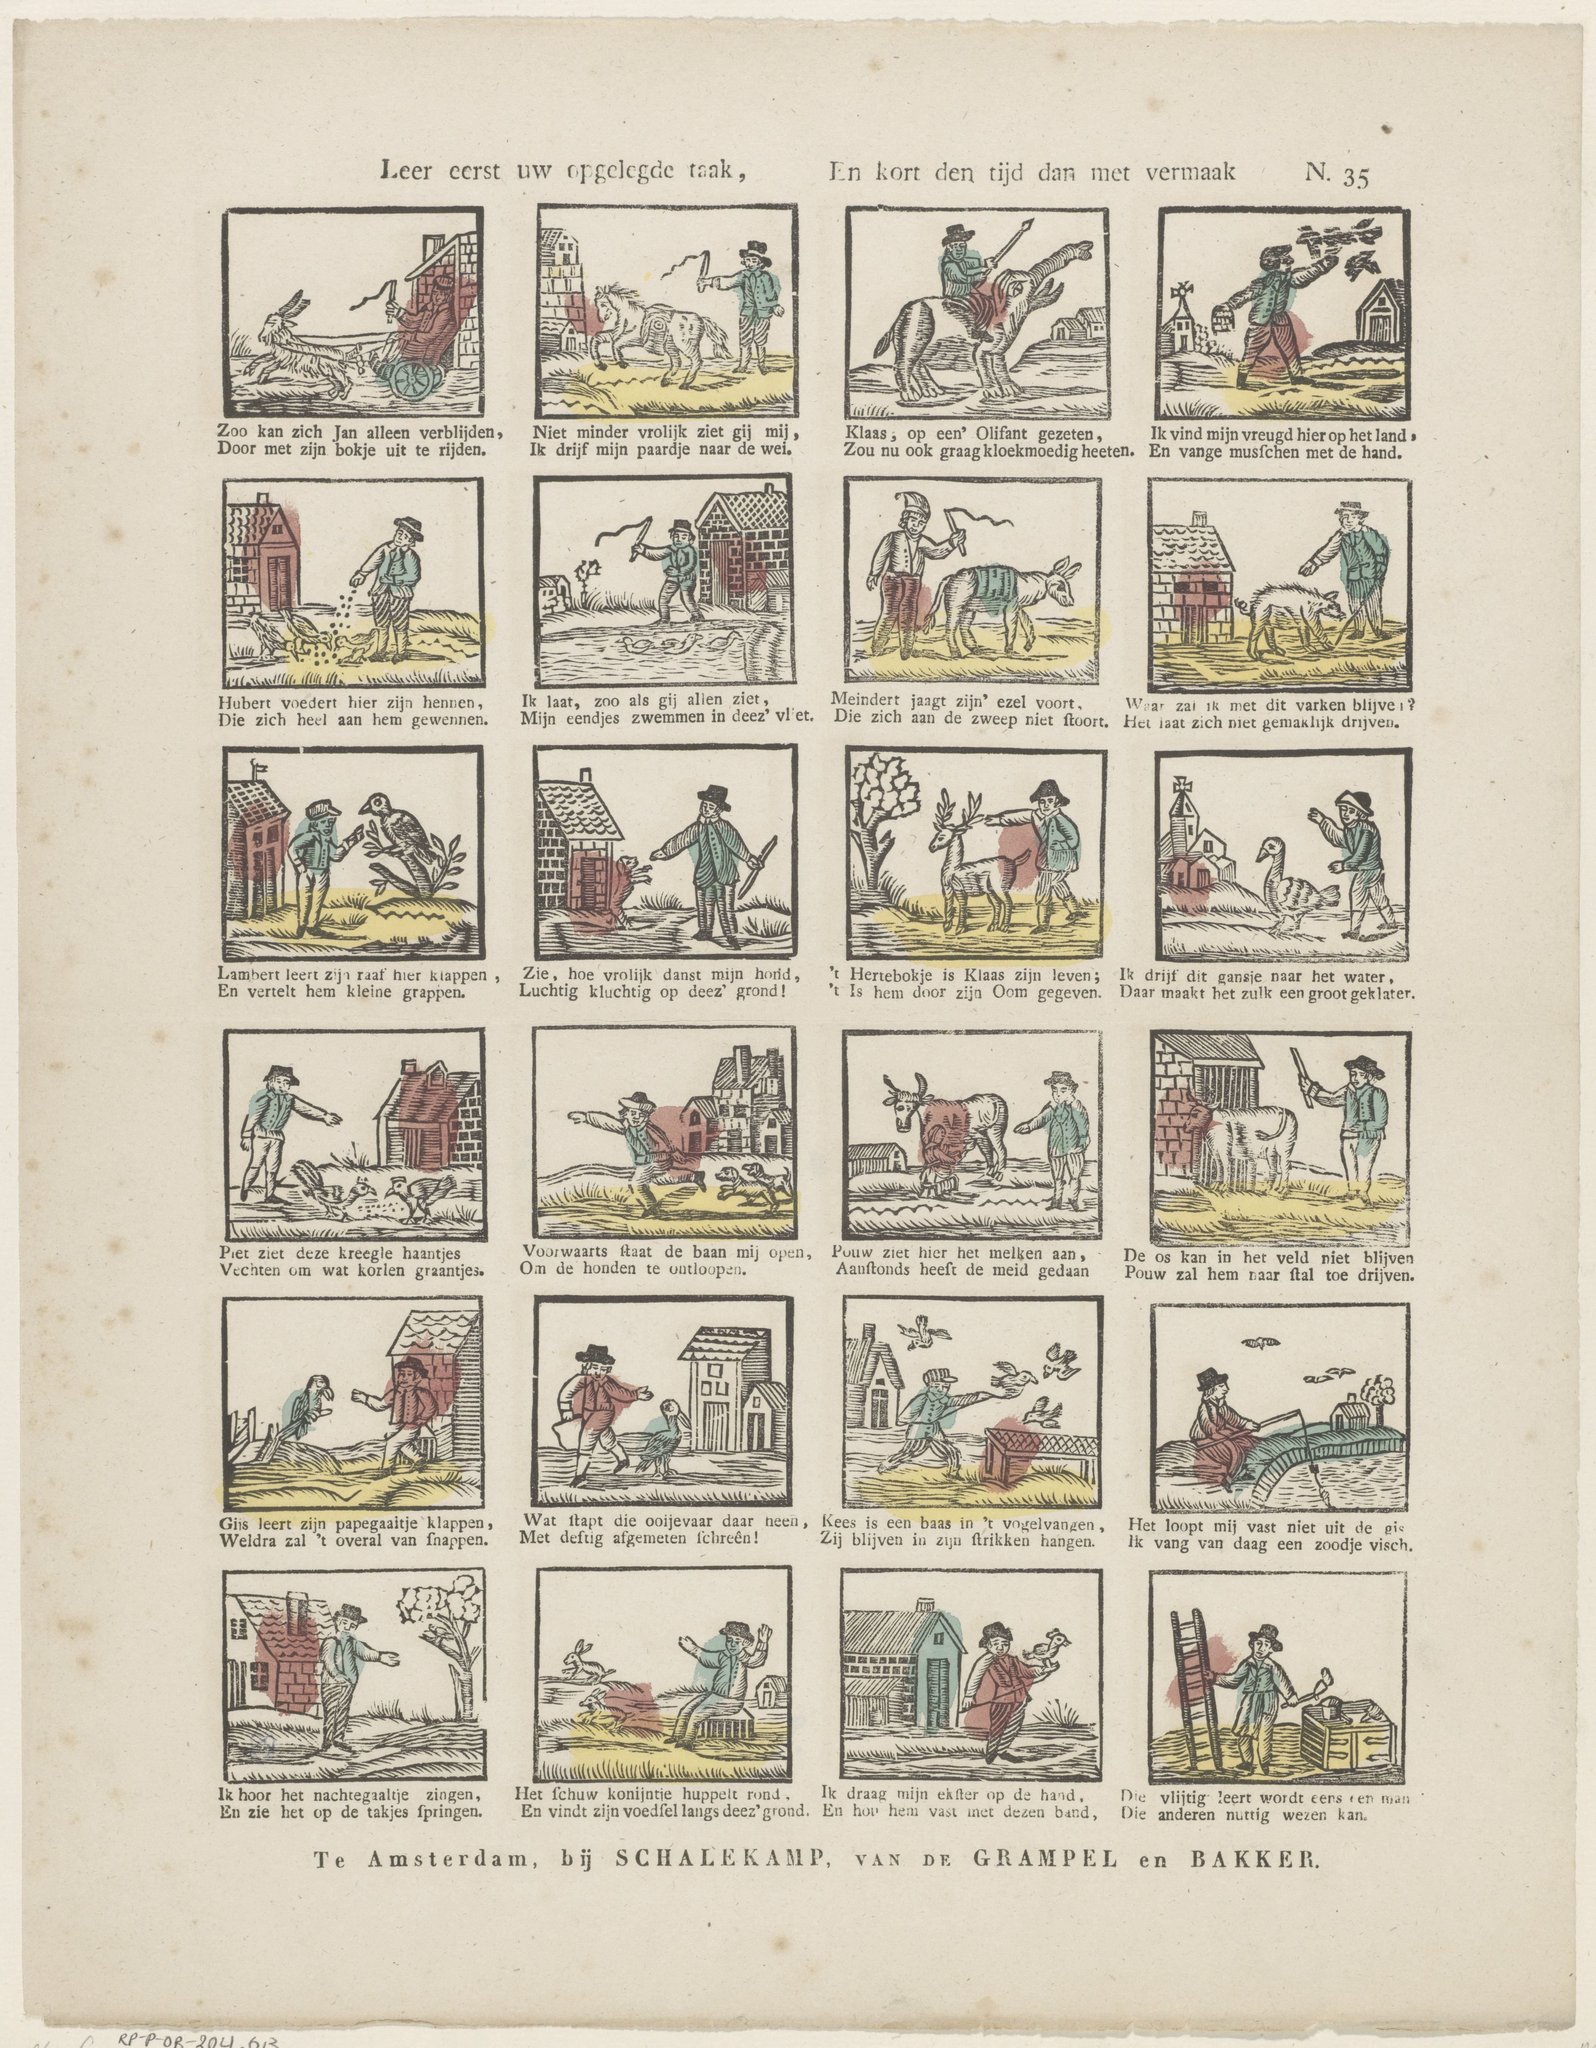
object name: popular print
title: Leer eerst uw opgelegde taak, / En kort den tijd dan met vermaak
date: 1822-1849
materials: paper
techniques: colour, letterpress printing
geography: deventer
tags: child playing with animals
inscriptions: collector's mark: Lugt 2760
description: Blad met 24 voorstellingen van kinderen die spelen met dieren. Onder elke afbeelding een tweeregelig vers. Genummerd rechtsboven: N. 35.